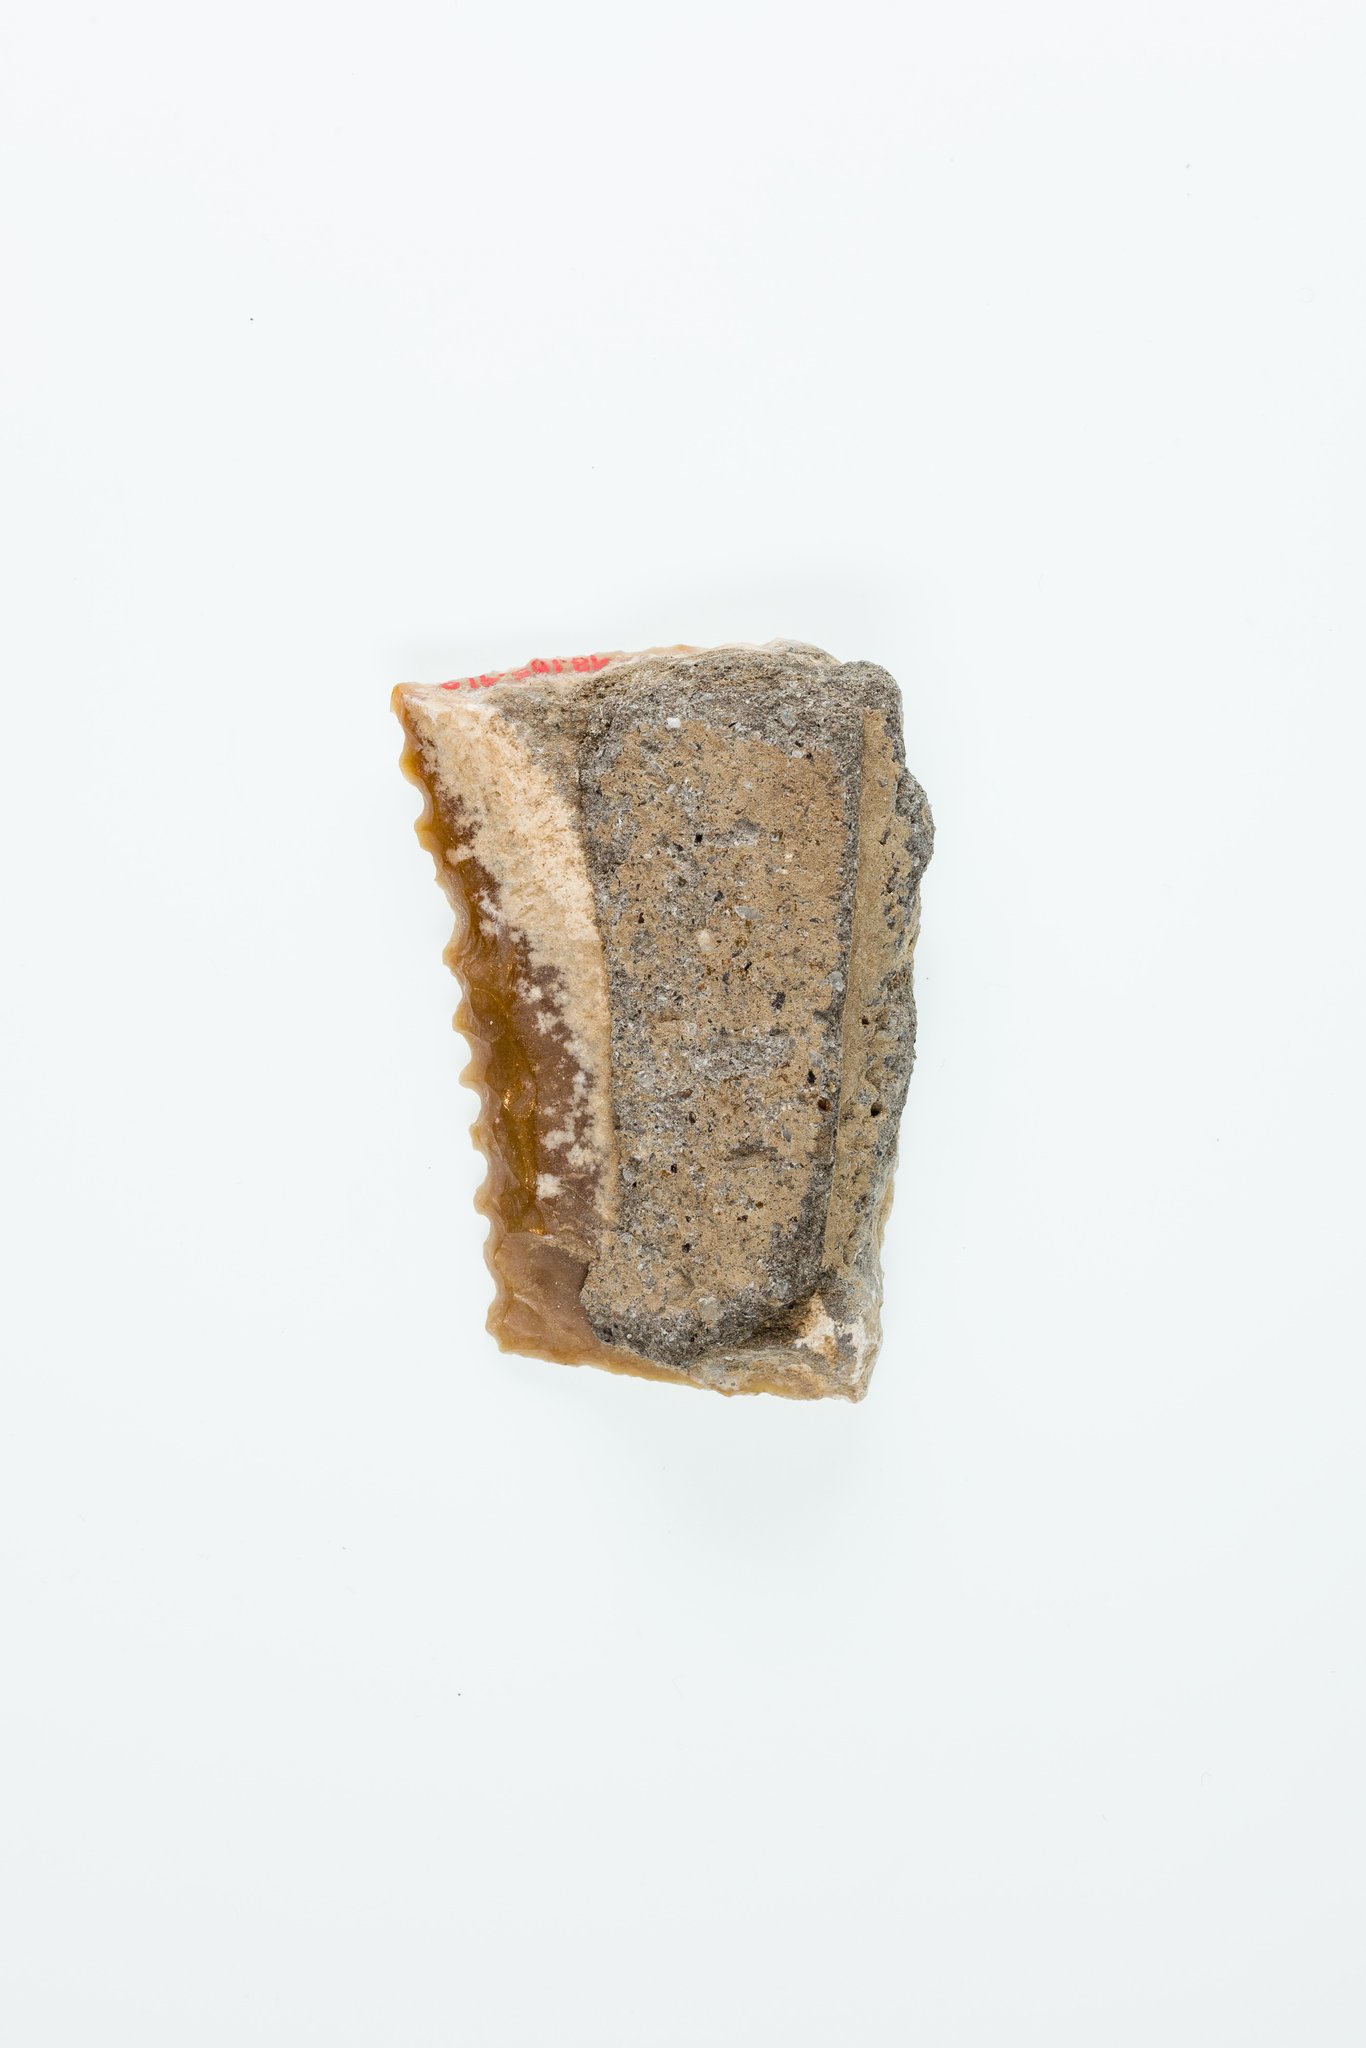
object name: sickle, denticulate, truncated, backed, geometric, tool, element, adhesive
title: Sickle Insert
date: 1184-664 BCE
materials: stone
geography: egypt